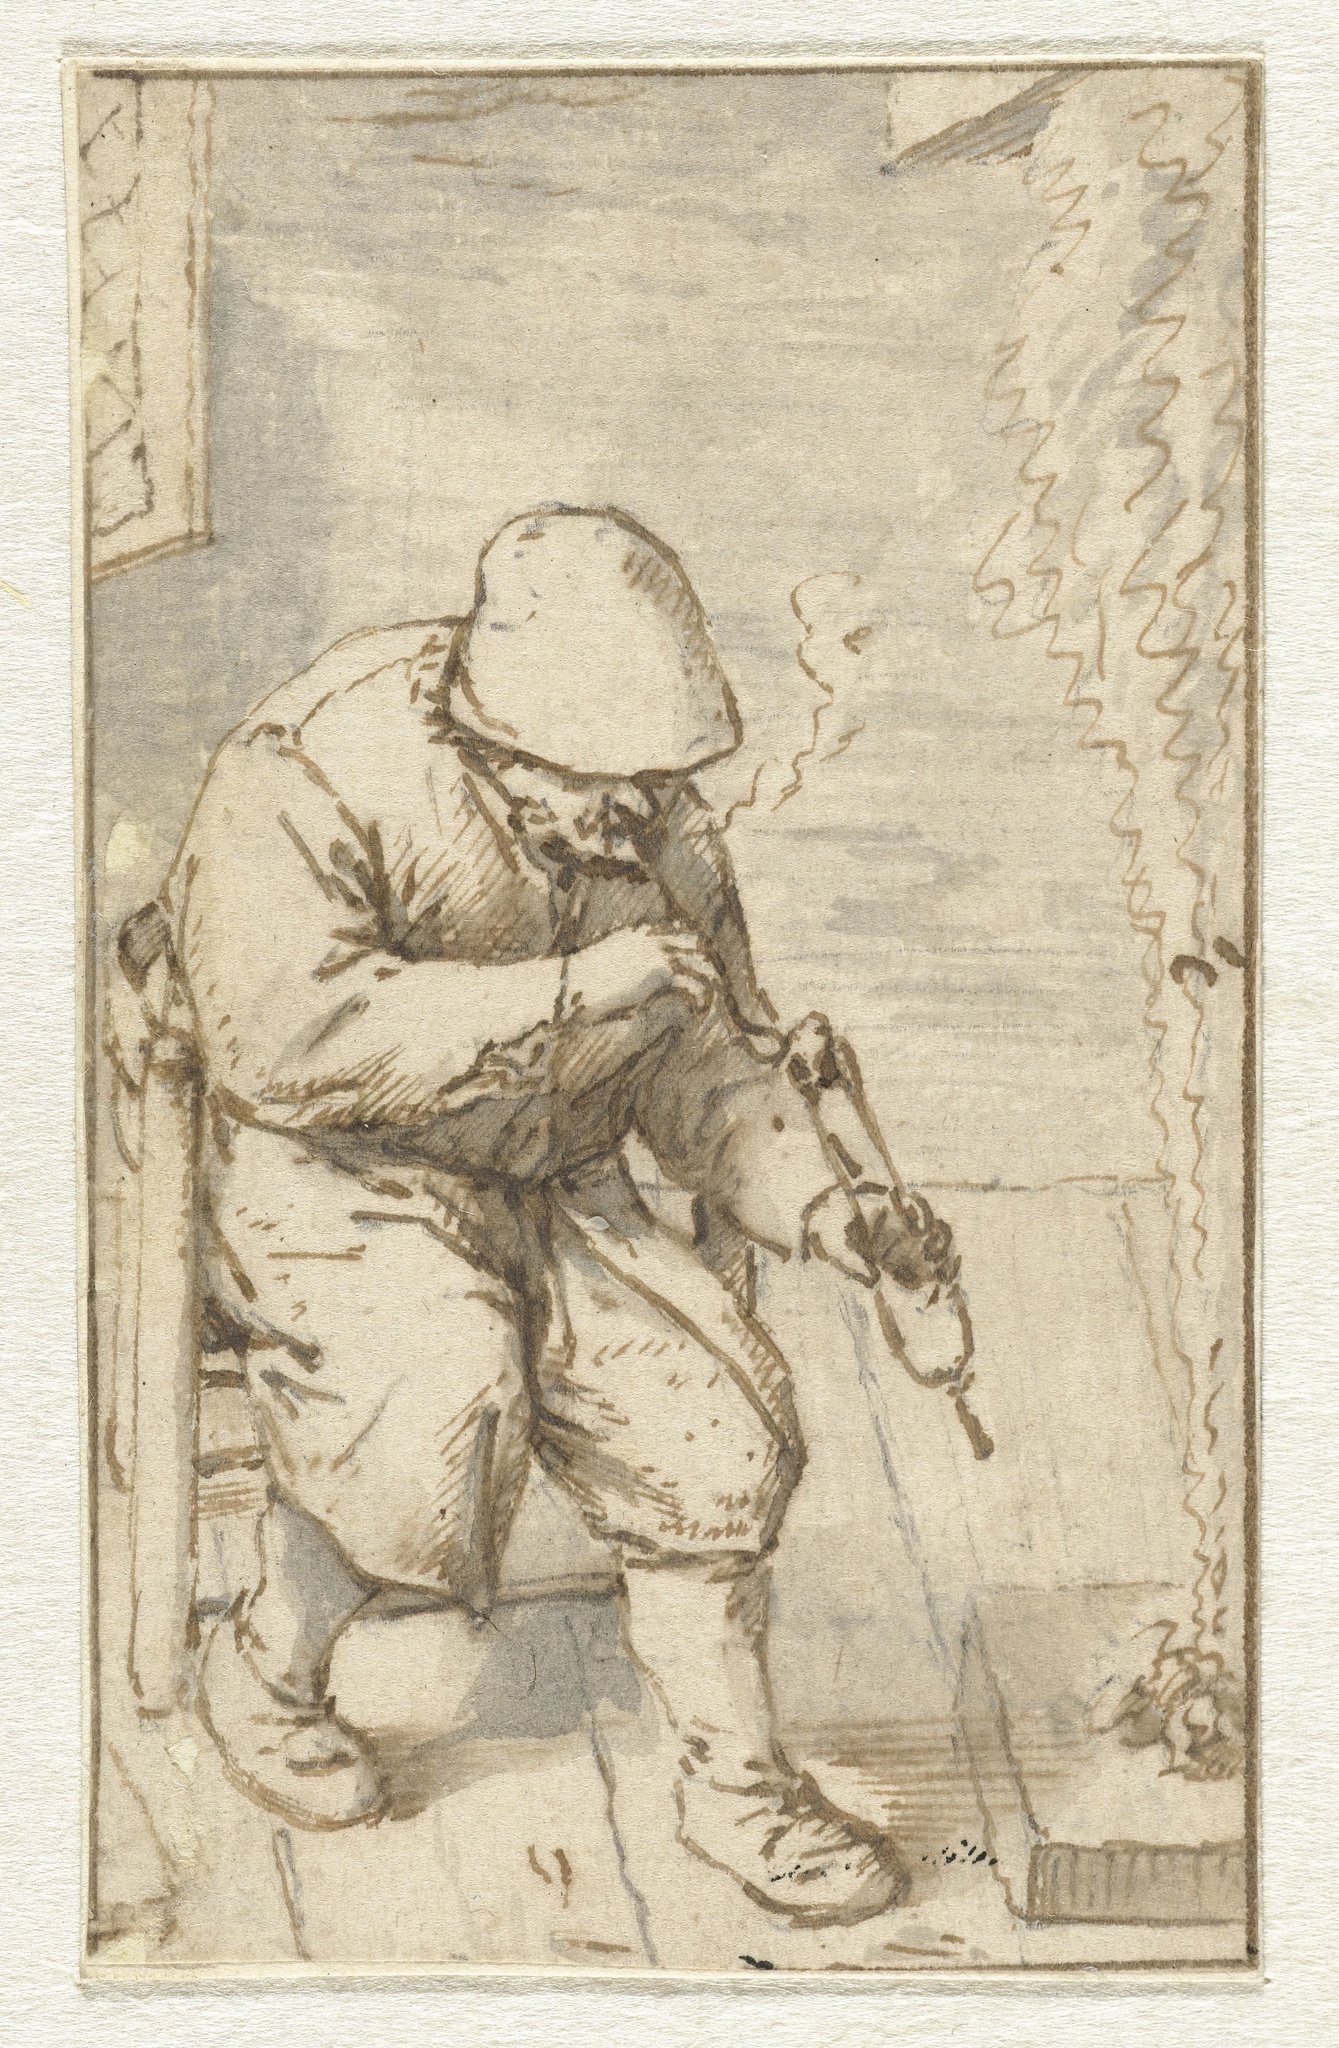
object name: drawing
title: Boer zittend bij een vuur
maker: Anonymous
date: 1670-1850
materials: ink, paper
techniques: brush, pen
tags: sitting figure, farmers, fire-tongs, pipe ~ tobacco (+ taking (particular) foodstuffs: eating, drinking, smoking, chewing, etc.)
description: Een boer, bij het vuur gezeten, steekt met een vuurtang zijn pijp aan.